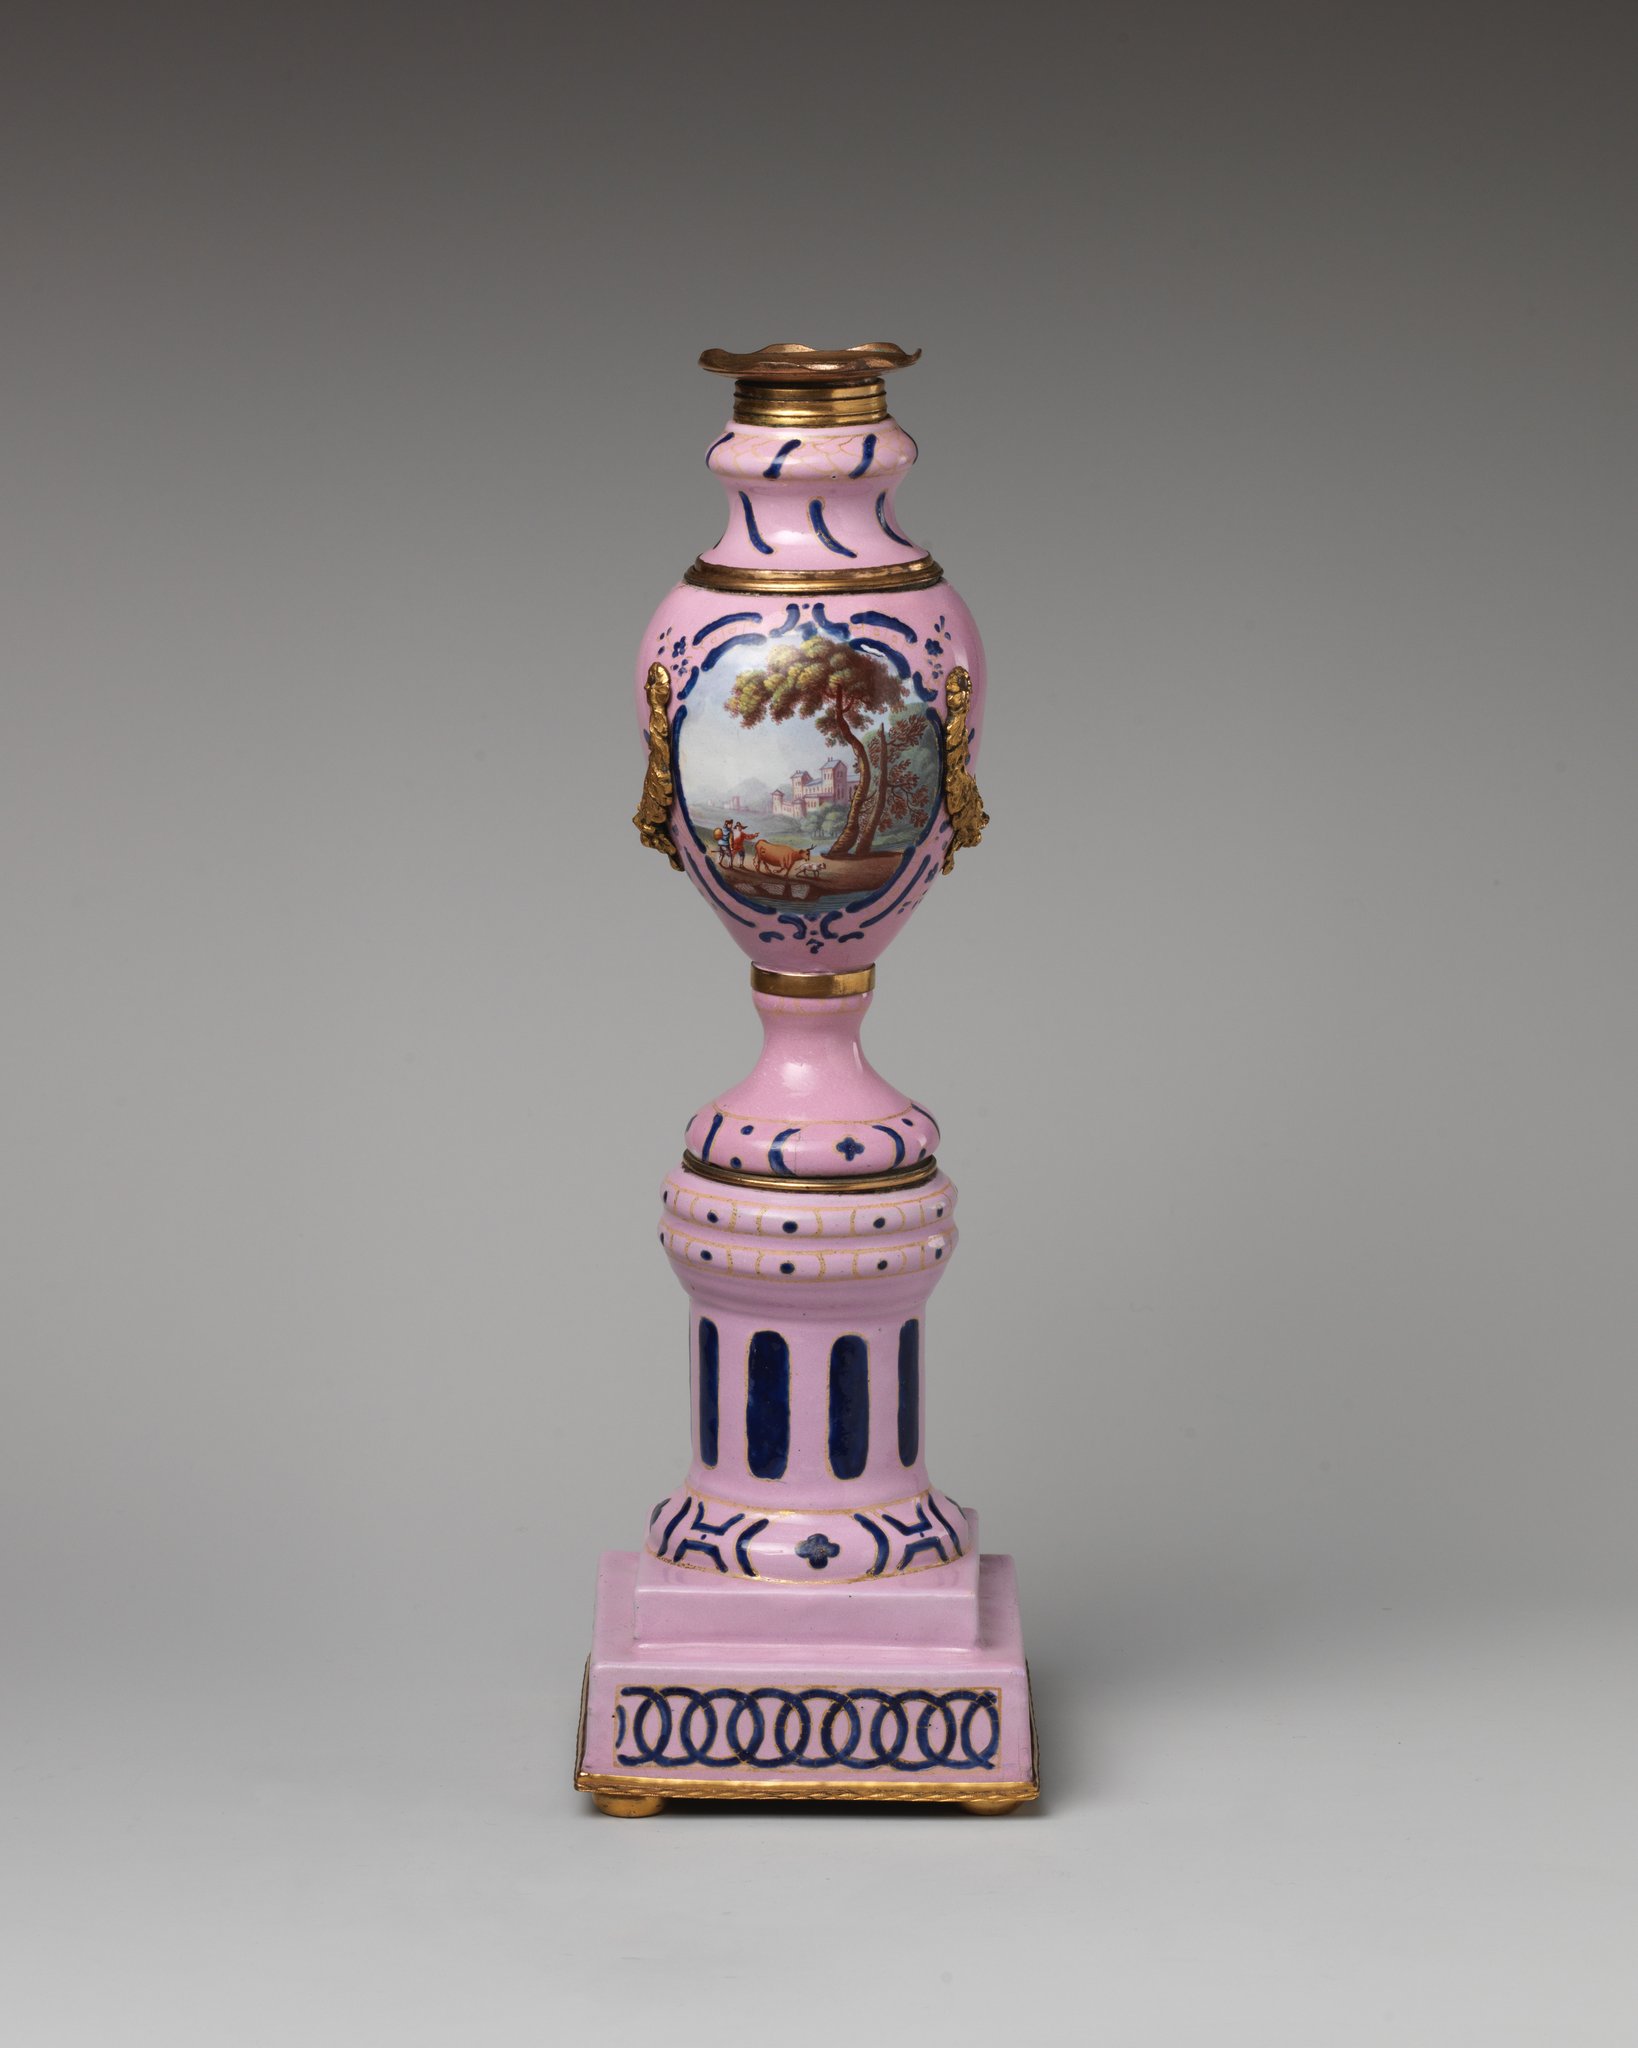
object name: cassolette with cover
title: Cassolette with cover (one of a pair)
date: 1765-1775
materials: copper, enamel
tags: buildings,cows,landscapes,trees